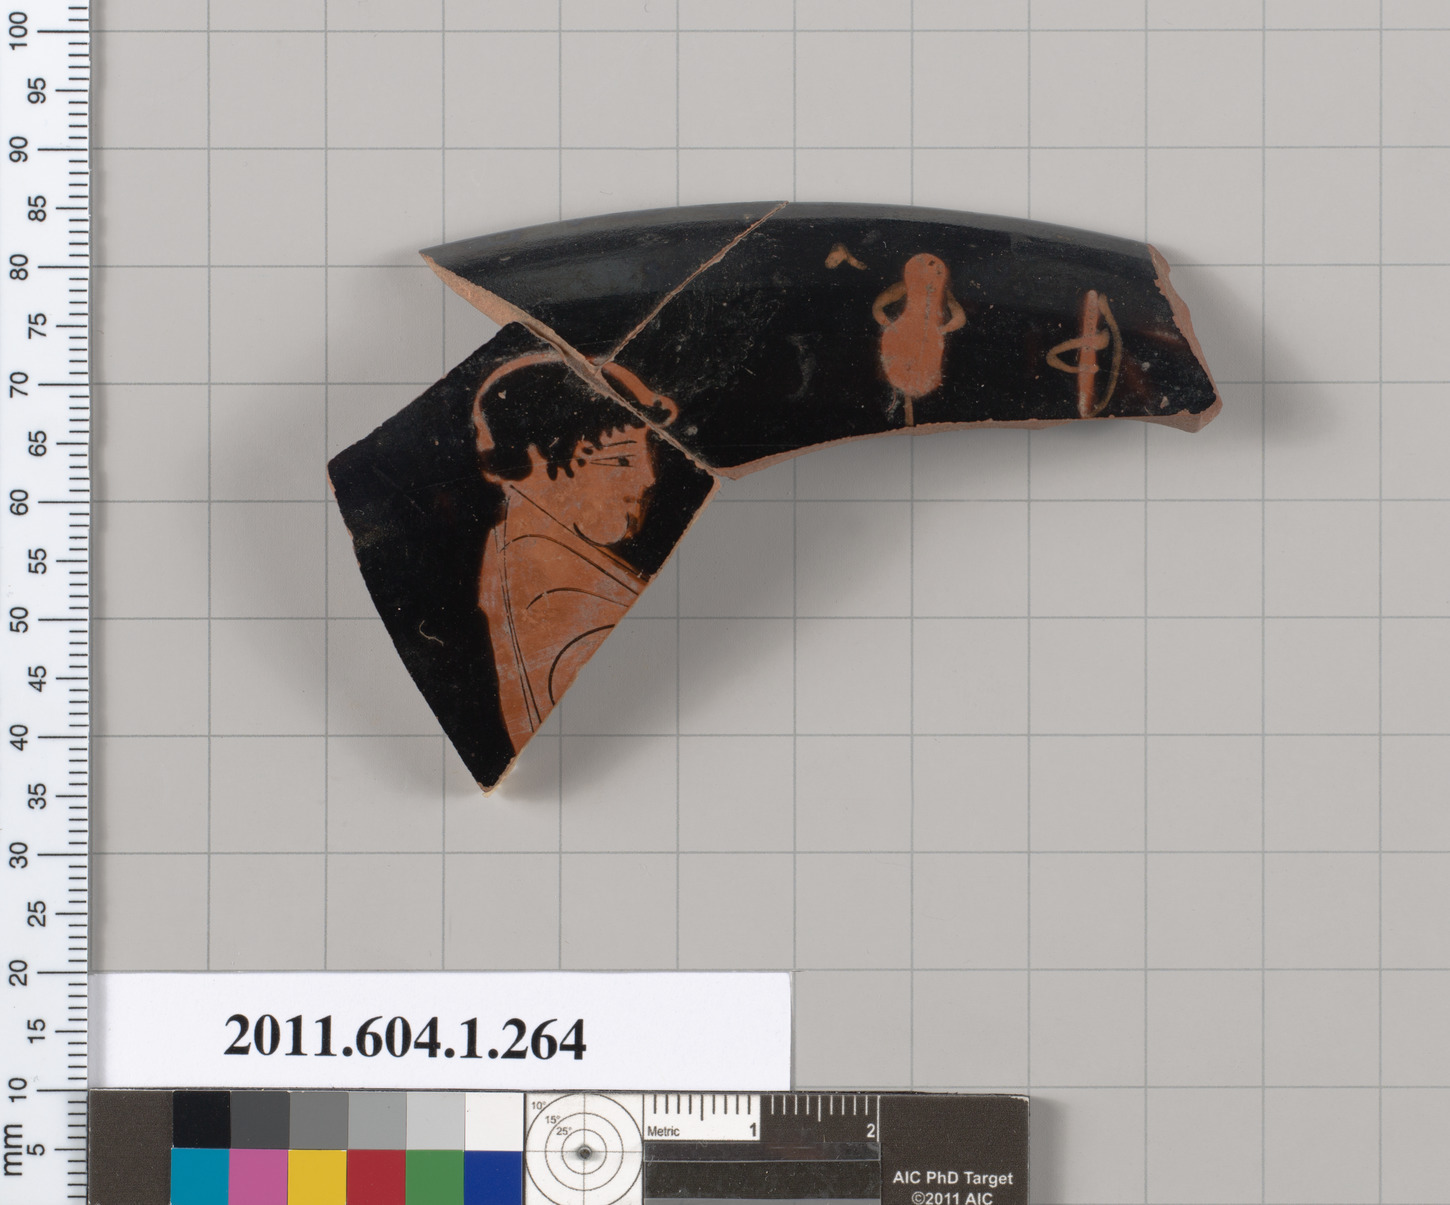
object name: kylix fragment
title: Terracotta fragment of a kylix (drinking cup)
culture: greek, attic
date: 475-451 BCE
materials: terracotta